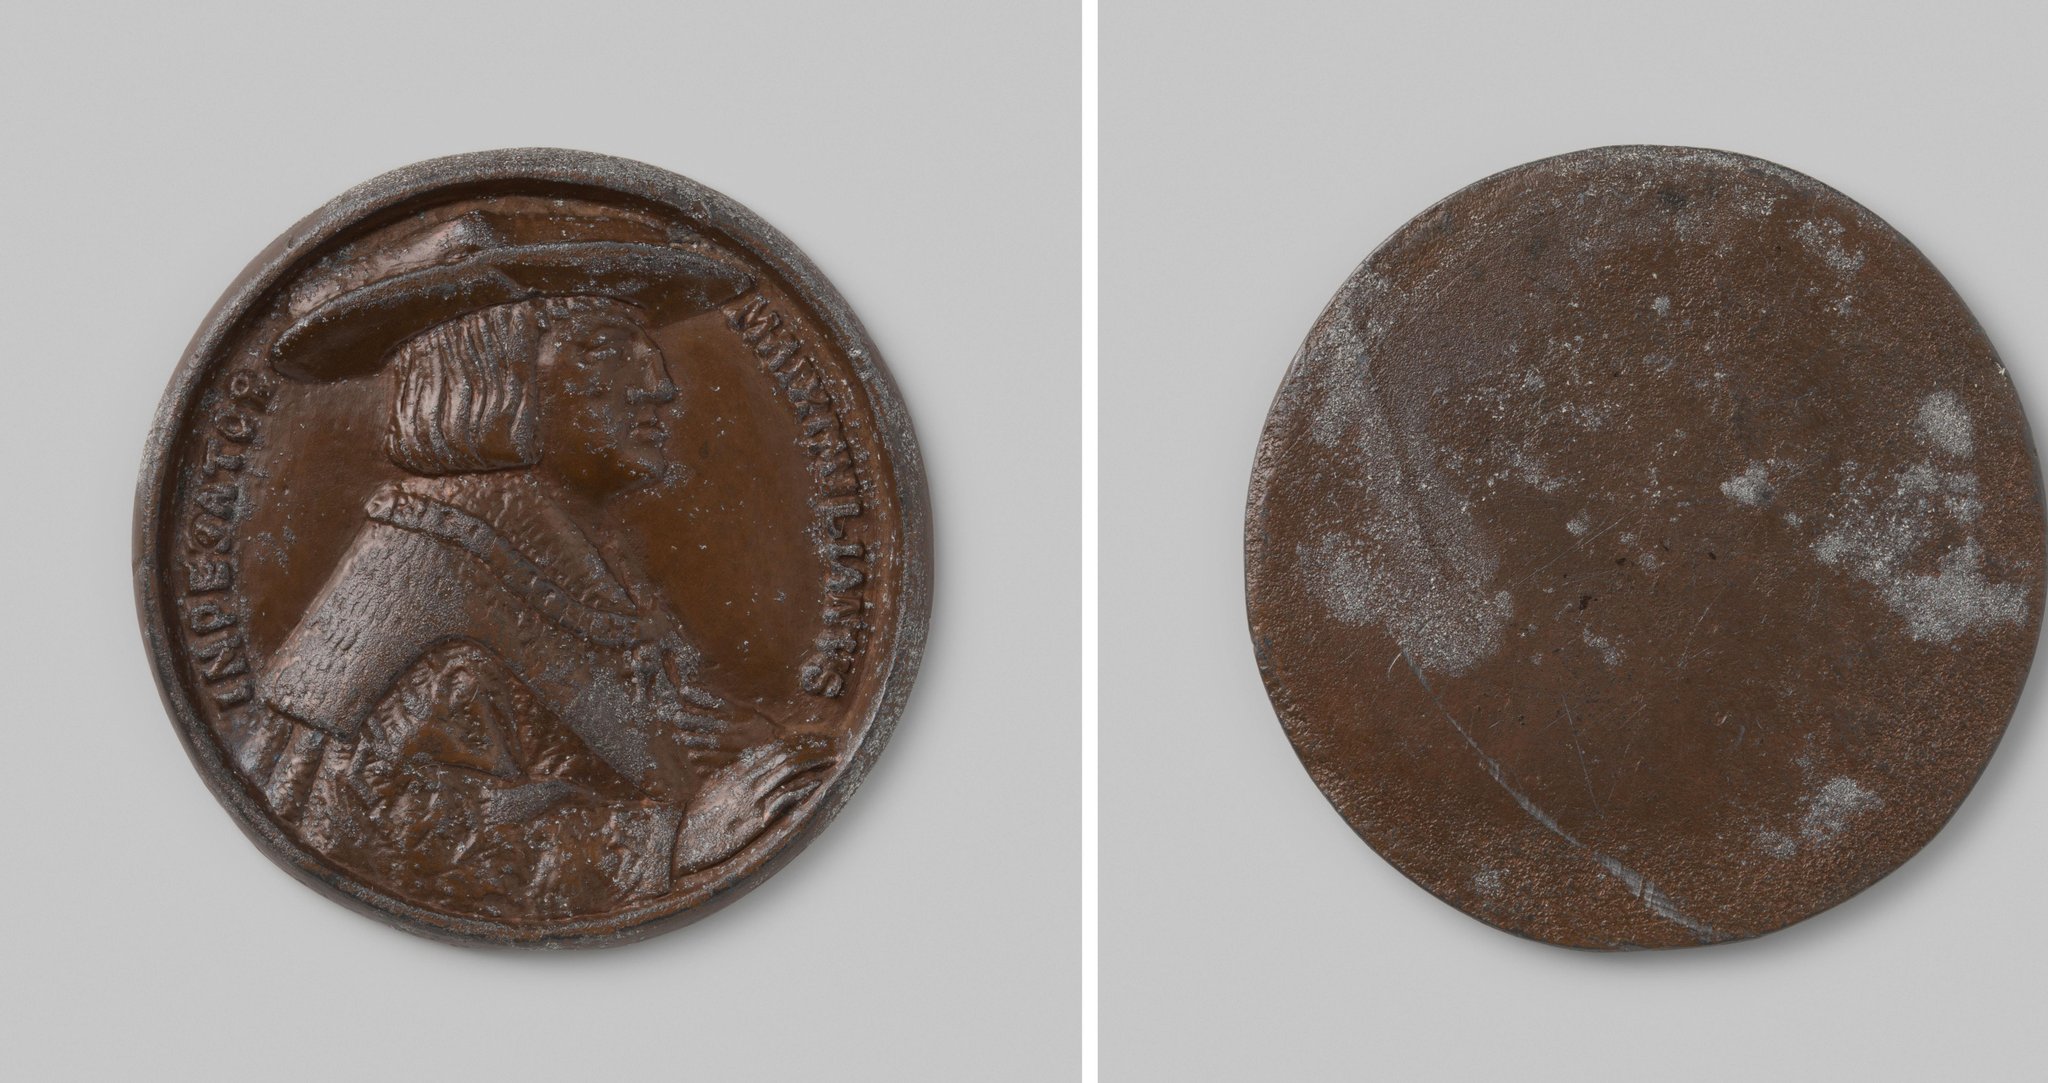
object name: history medal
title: Maximiliaan I, Duits keizer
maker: Anonymous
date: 1516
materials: bronze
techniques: casting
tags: maximilian i (holy roman emperor)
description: Eenzijdige bronzen penning. Voorzijde: borststuk man binnen omschrift. Keerzijde: blanco